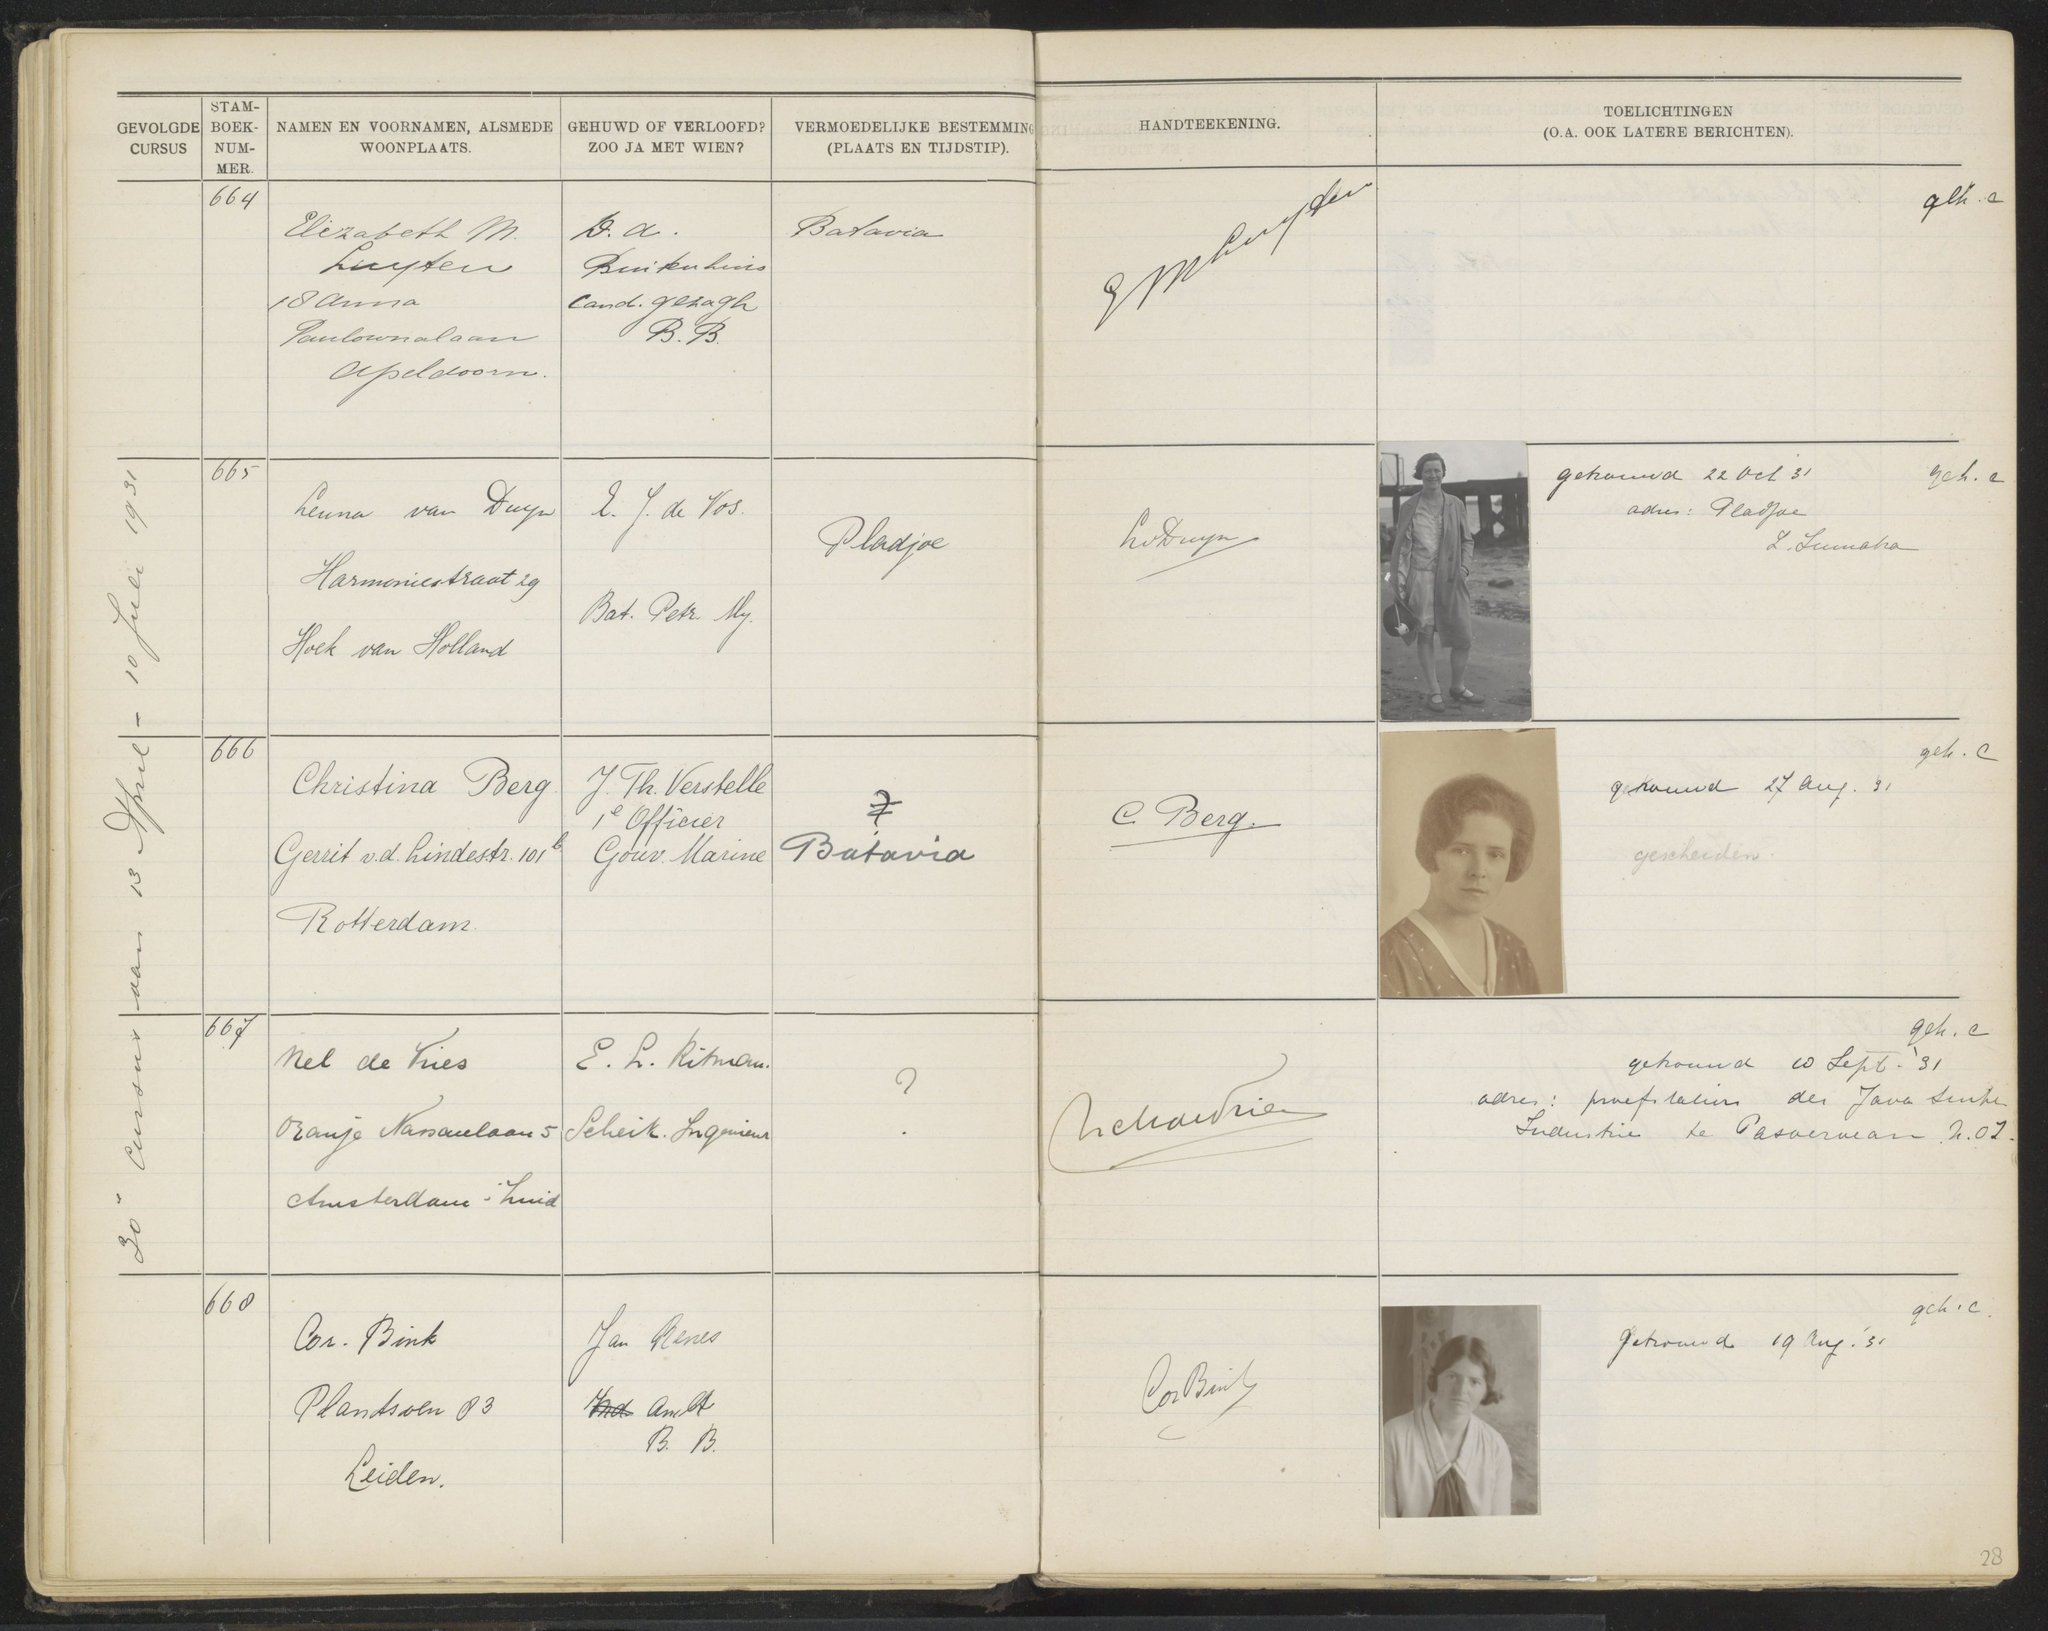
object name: photograph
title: Blad 28 uit Stamboek van de leerlingen der Koloniale School voor Meisjes en Vrouwen te 's-Gravenhage deel II (1930-1949)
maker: Anonymous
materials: paper, photographic support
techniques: photography, printing, writing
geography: the hague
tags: further education (+ pupil), further education, the hague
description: Twee pagina's met gegevens van de deelnemers aan de 30e driemaandelijkse cursus van 13 april tot en met 10 juli 1931, stamboeknummers 664 tot en met 668. Onderdeel van Stamboek van de leerlingen der Koloniale School voor Meisjes en Vrouwen te 's-Gravenhage deel II (1930-1949).